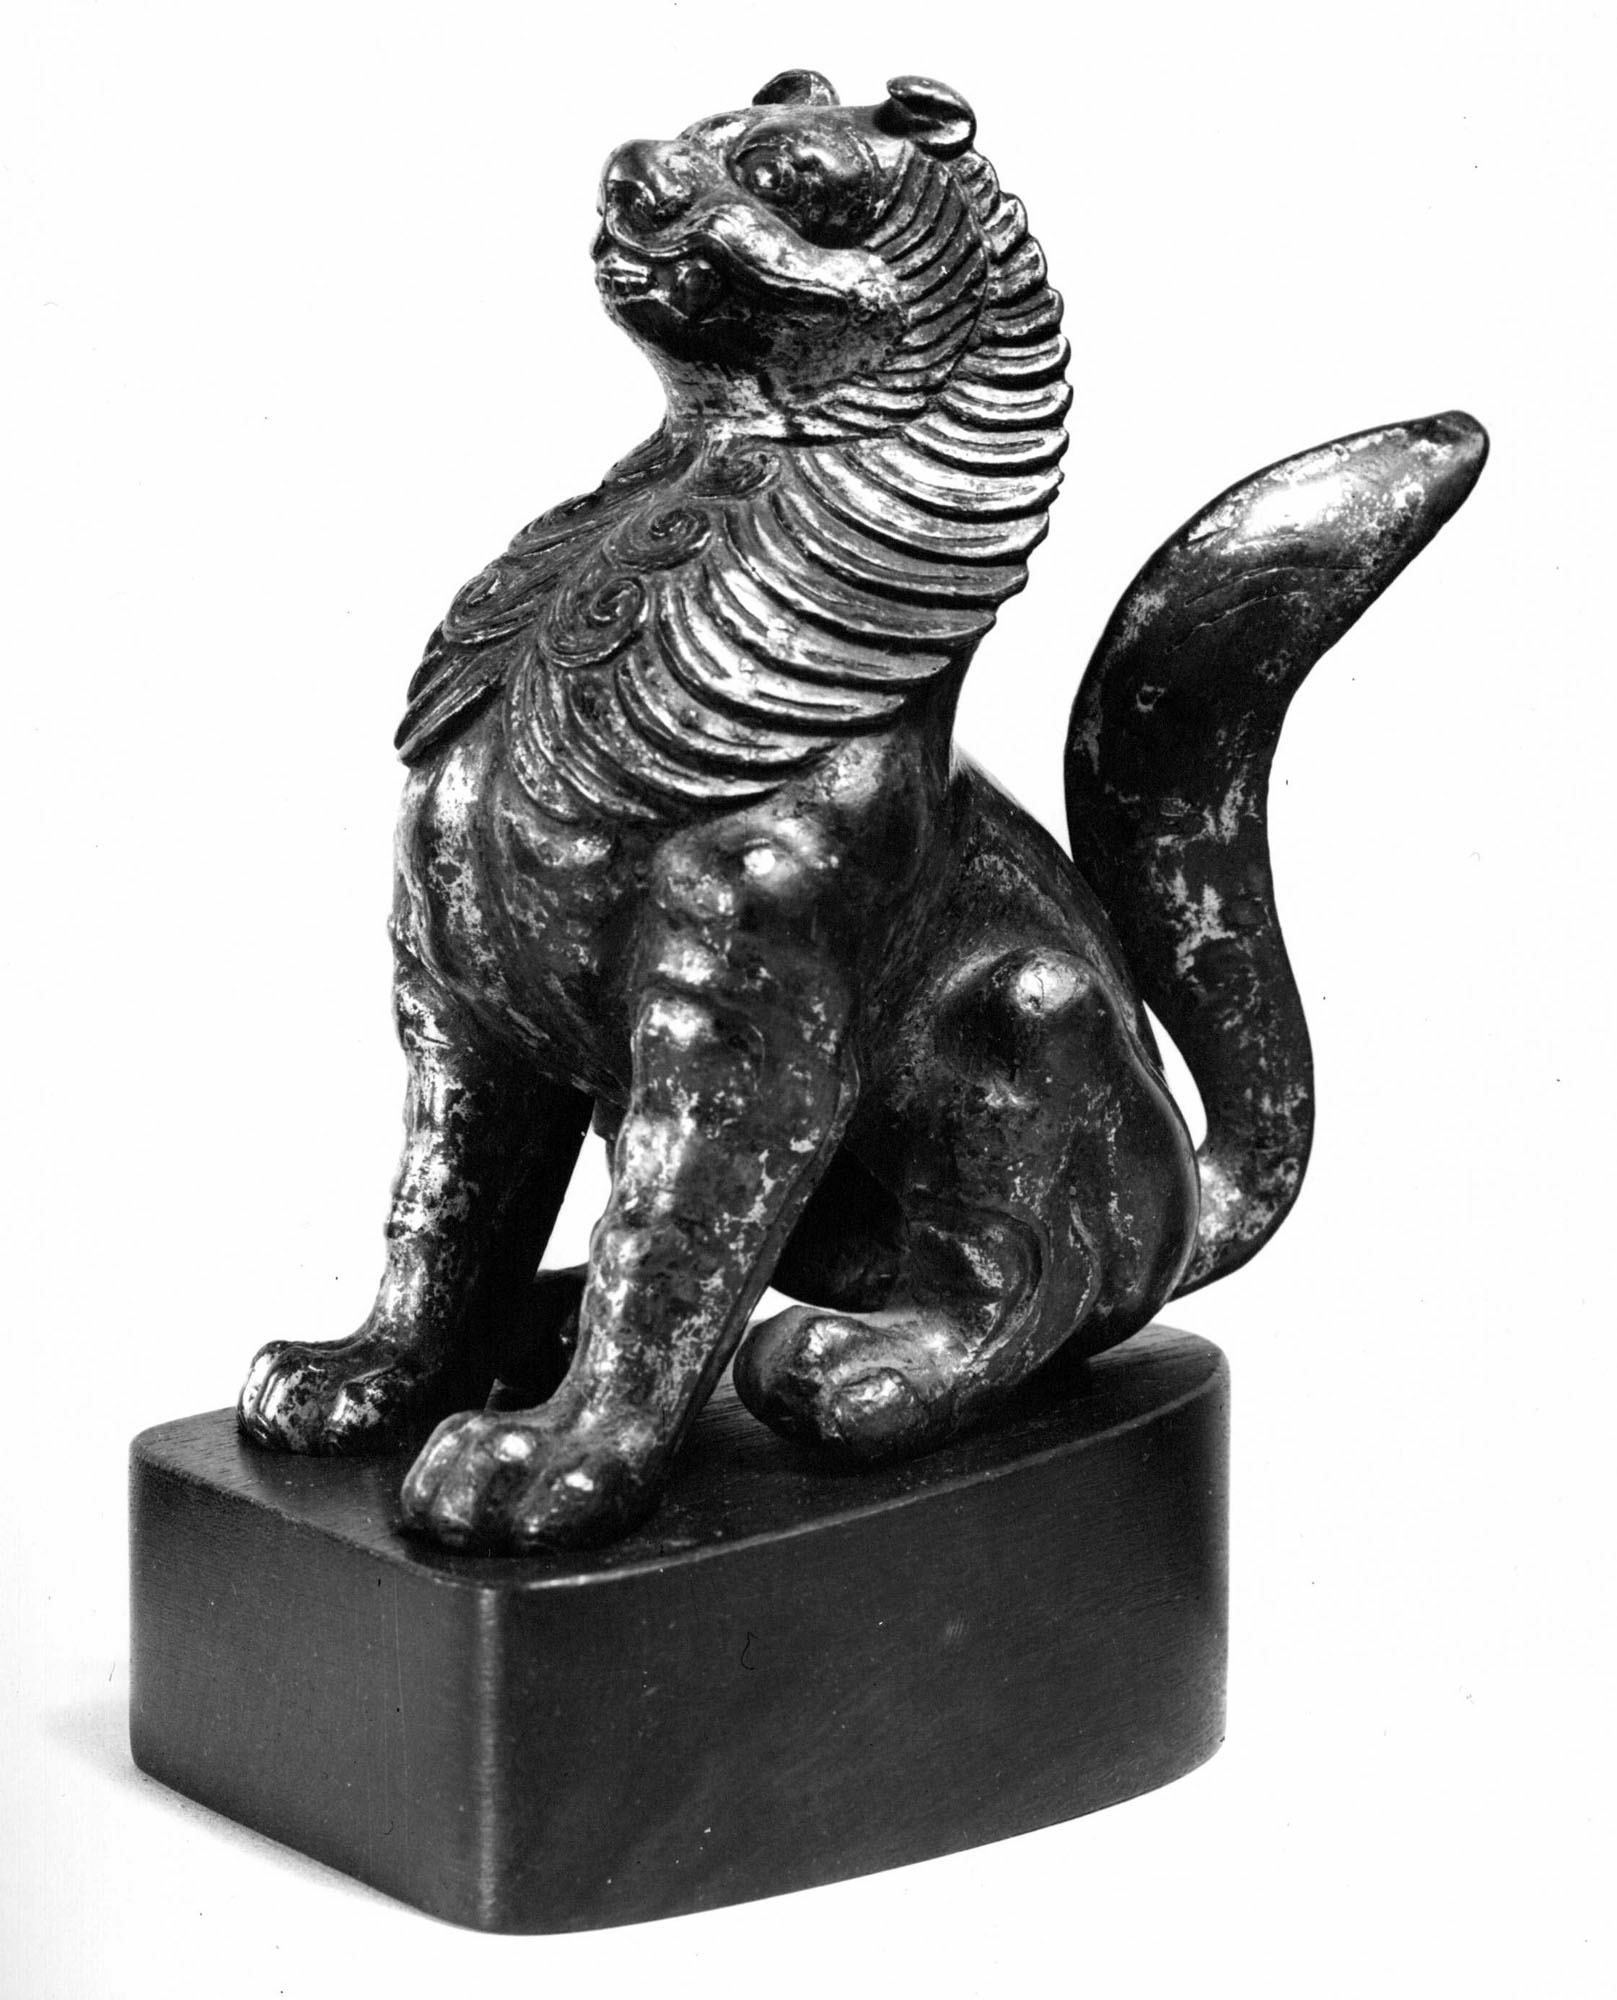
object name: figure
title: Seated lion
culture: chinese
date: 501-600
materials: bronze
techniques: gilding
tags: lions